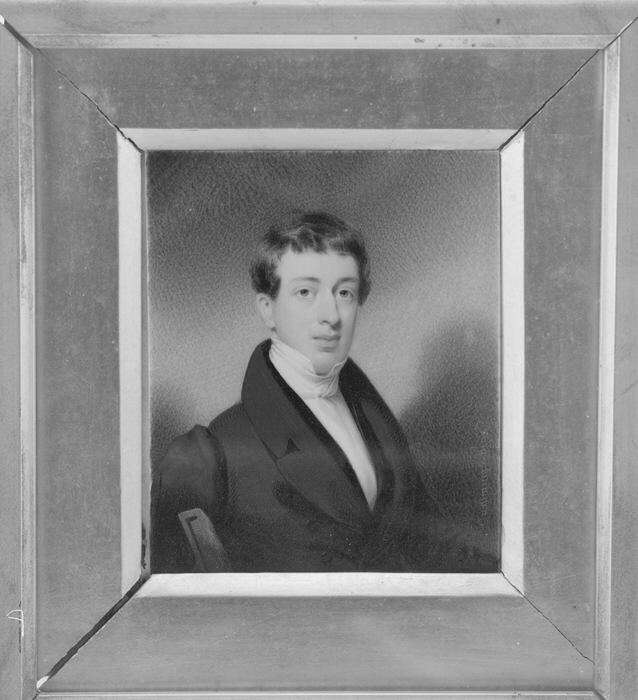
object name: painting, miniature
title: Portrait of a Gentleman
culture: american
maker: thomas seir cummings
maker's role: artist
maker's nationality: american, born england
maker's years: 1804-1894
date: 1825-1830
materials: ivory, watercolor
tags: men,portraits